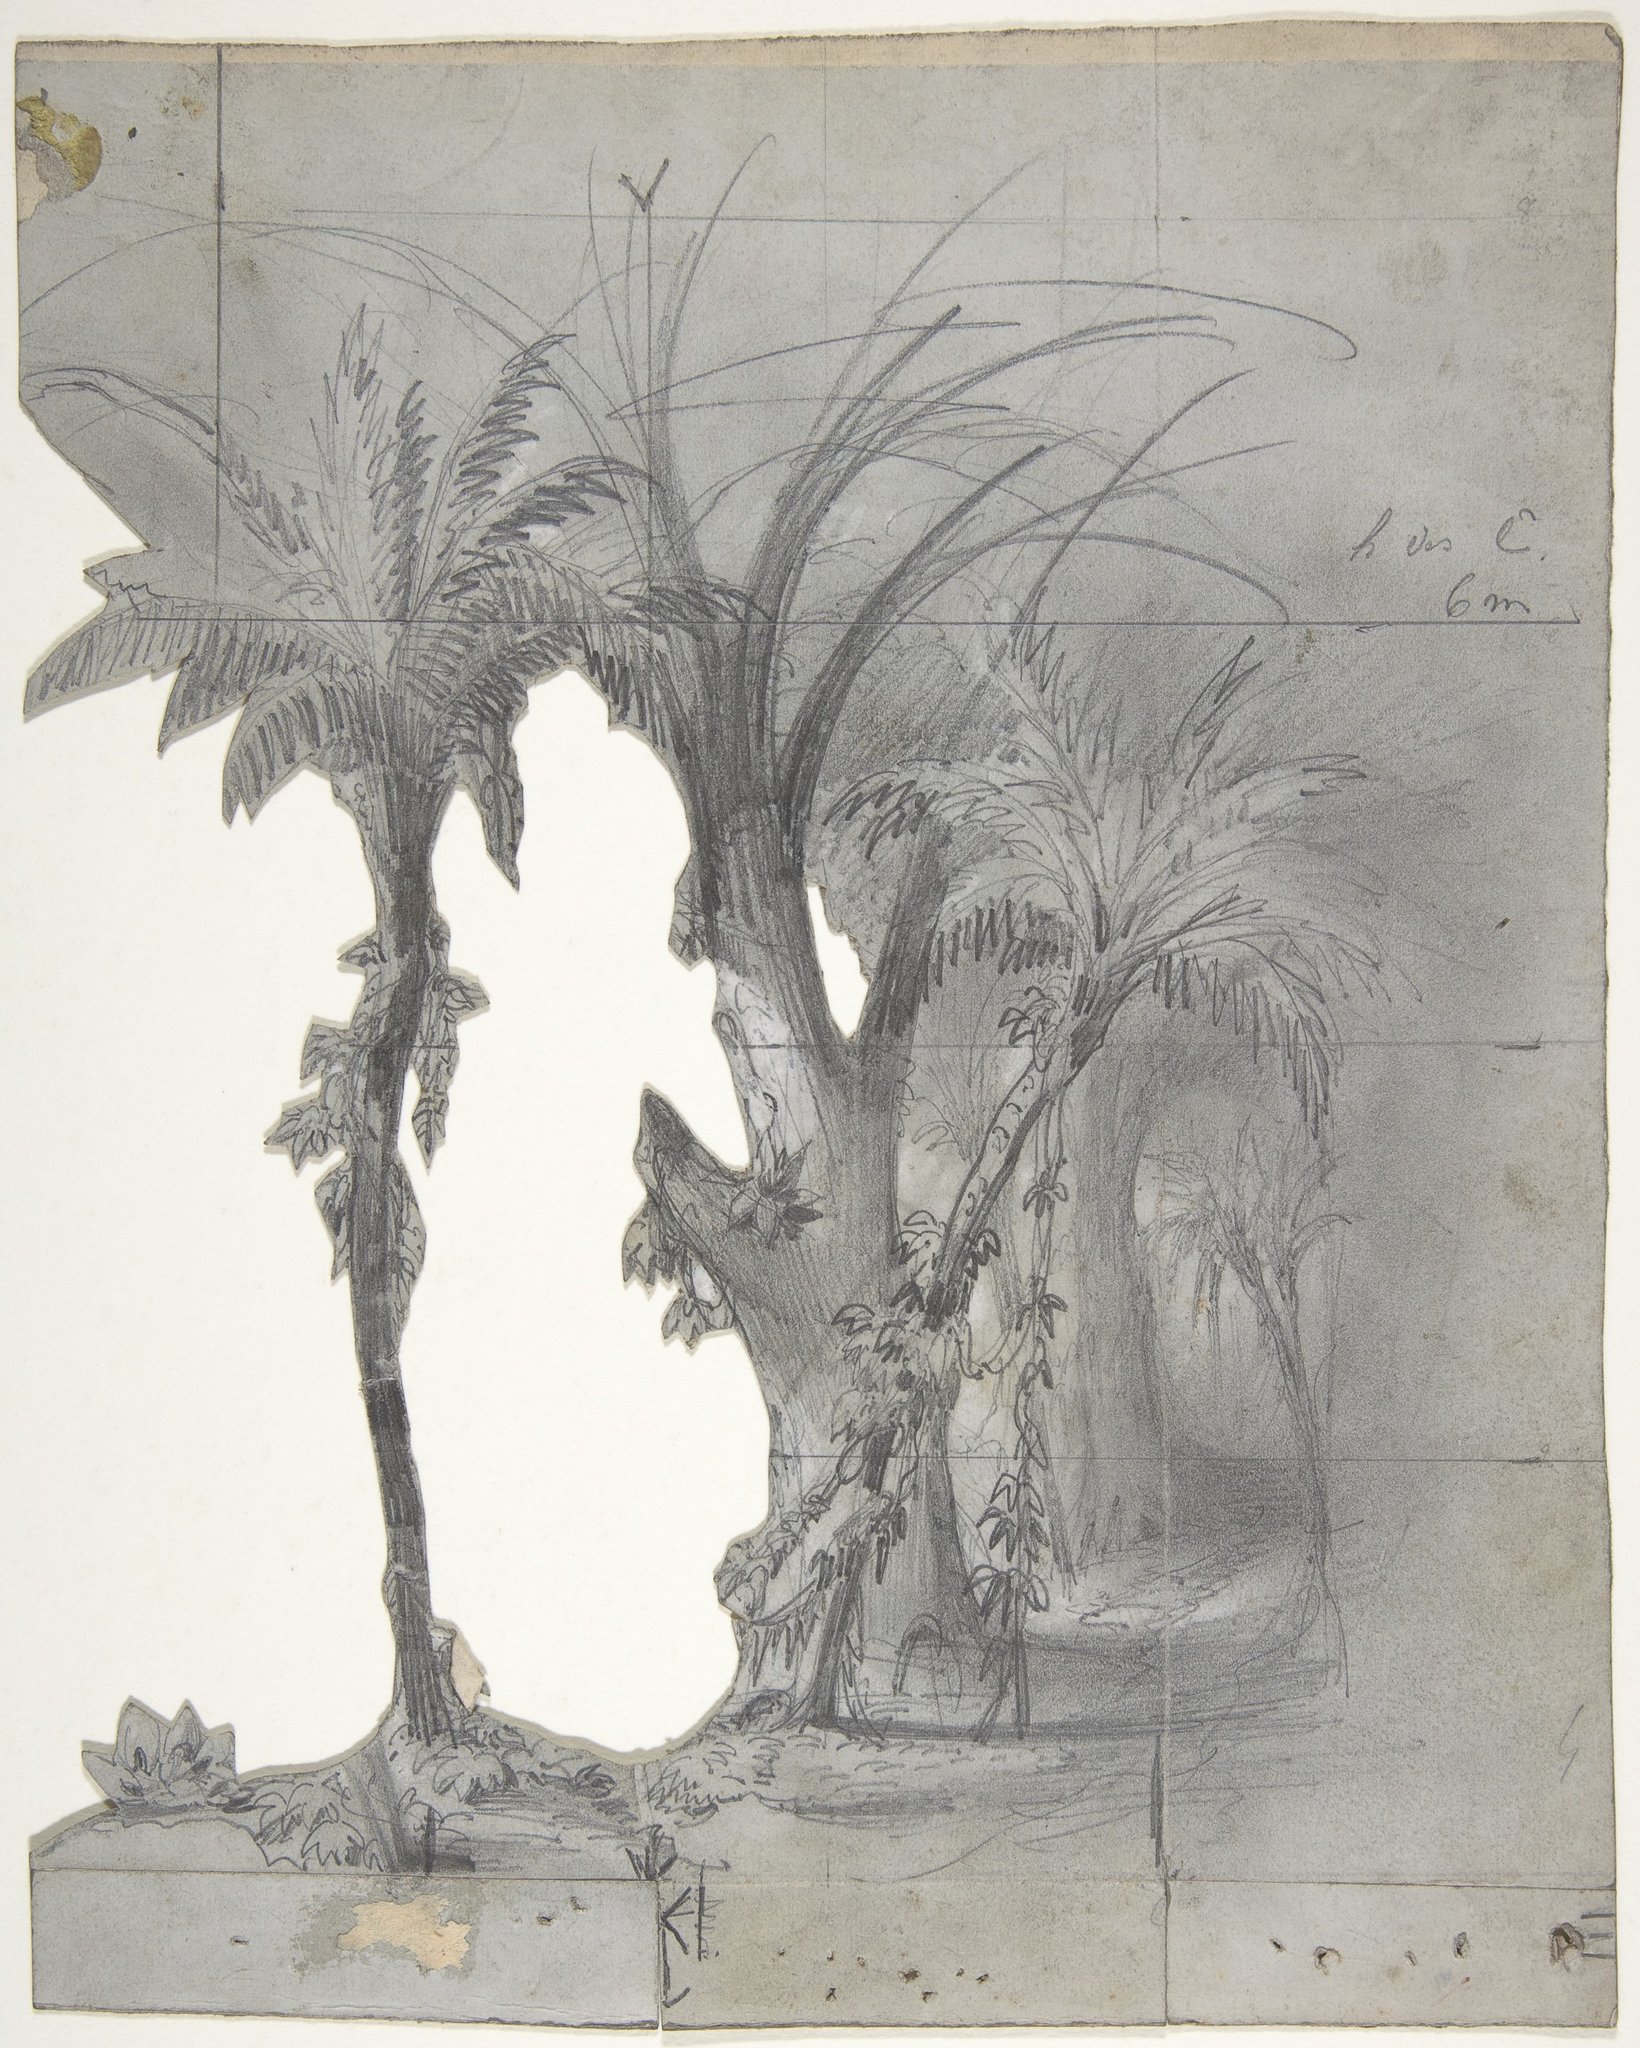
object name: drawing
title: Design for a Stage Set at the Opéra, Paris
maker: eugène cicéri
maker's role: artist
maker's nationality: french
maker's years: 1813-1890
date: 1830-1890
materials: graphite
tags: trees,stage design